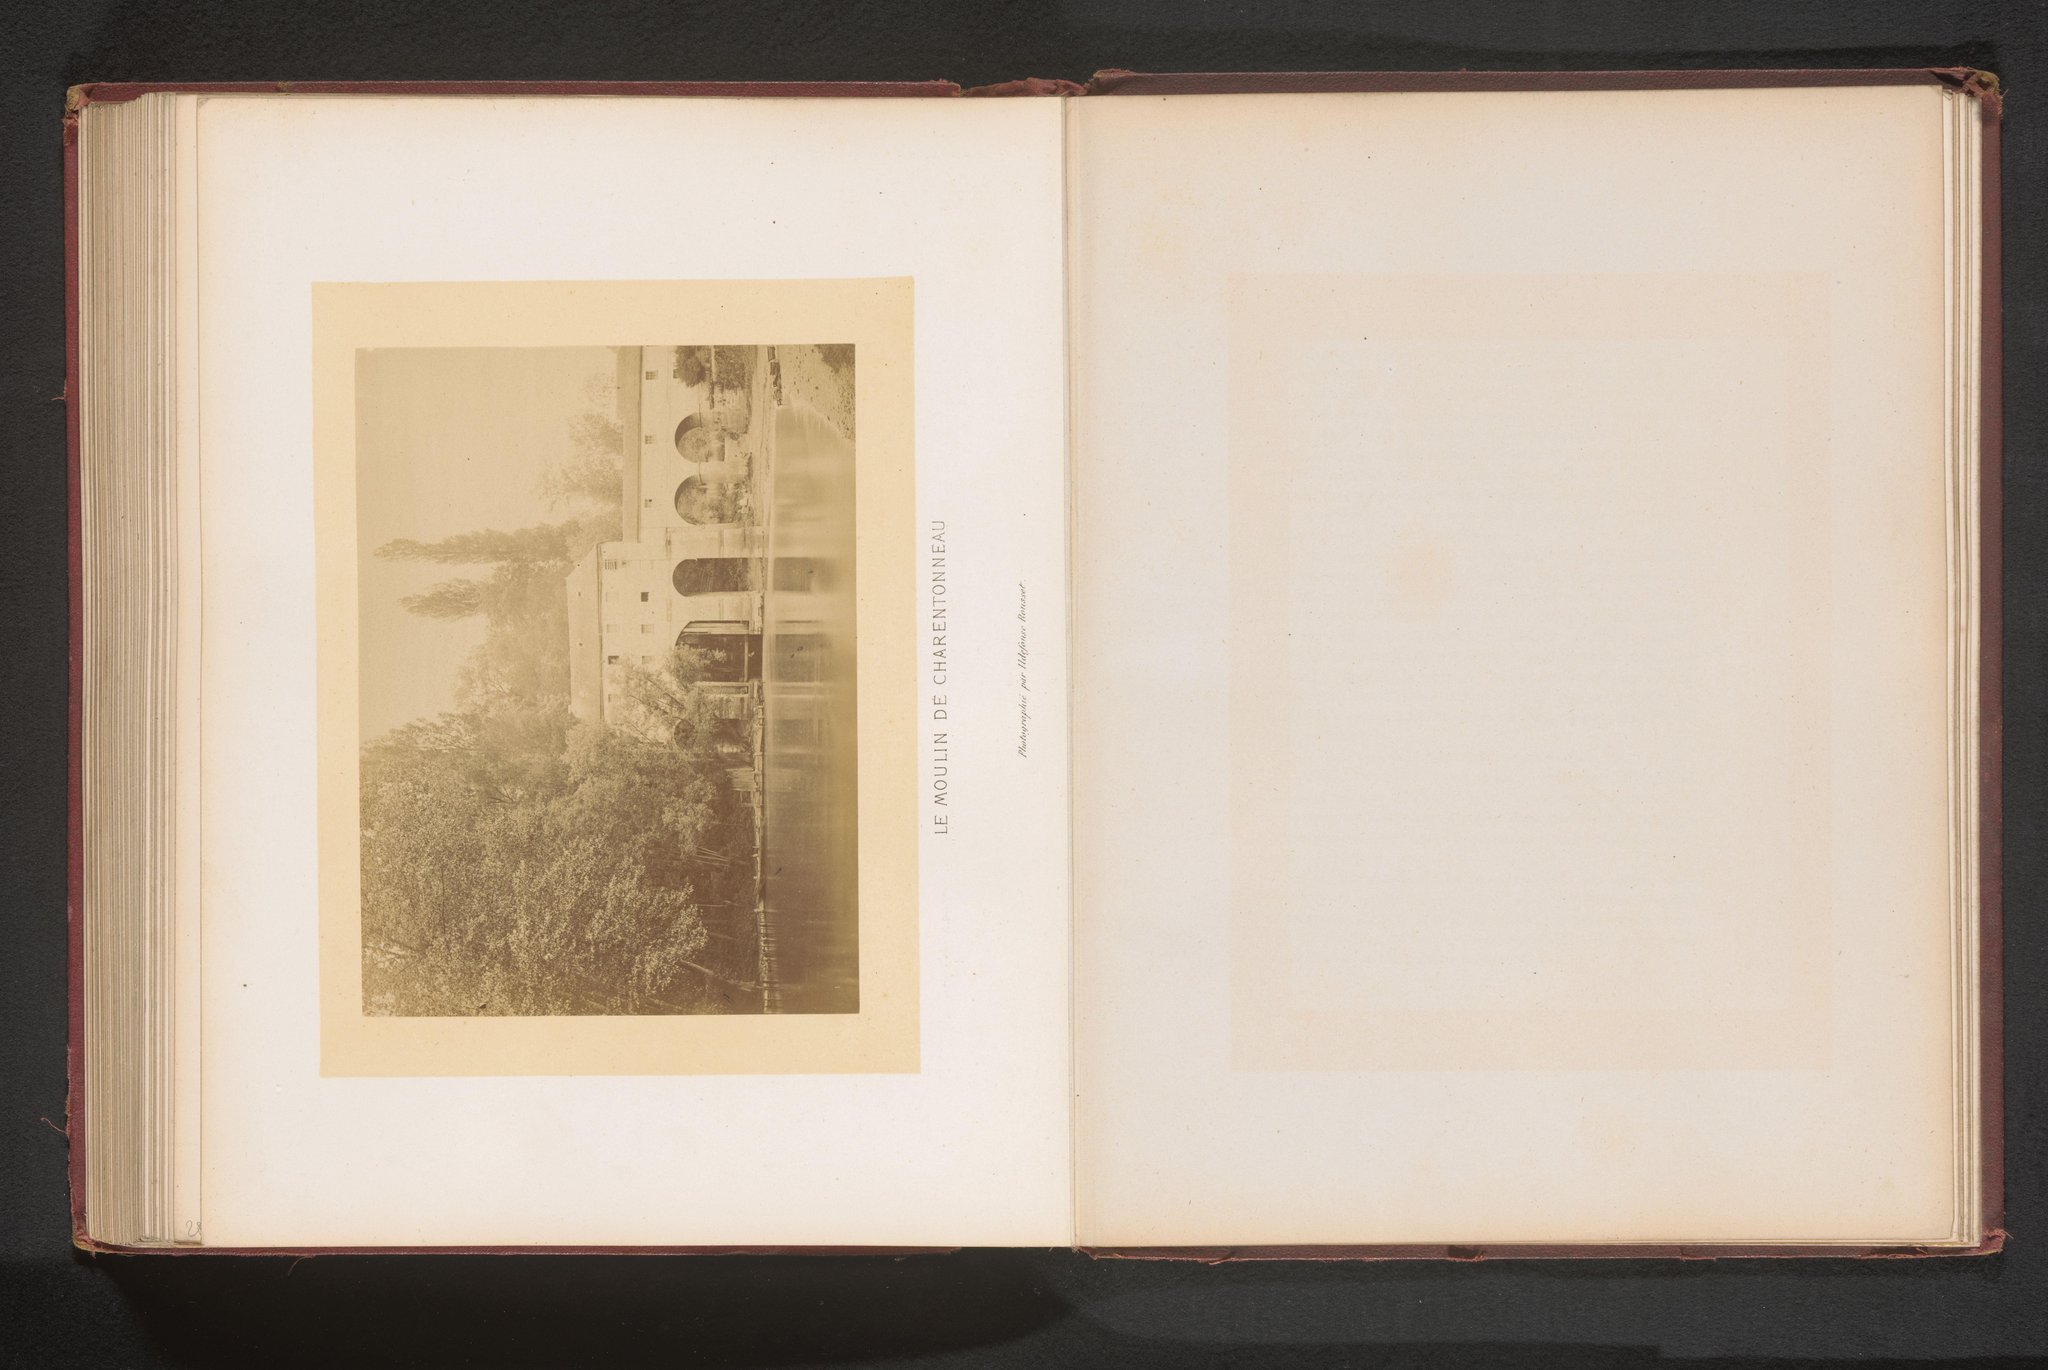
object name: page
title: Exterieur van de Moulin Brûlé in de Marne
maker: ildefonse rousset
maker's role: fotograaf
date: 1860-1865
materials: photographic support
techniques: albumen print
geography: ile-de-france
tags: river, watermill, façade (of house or building)